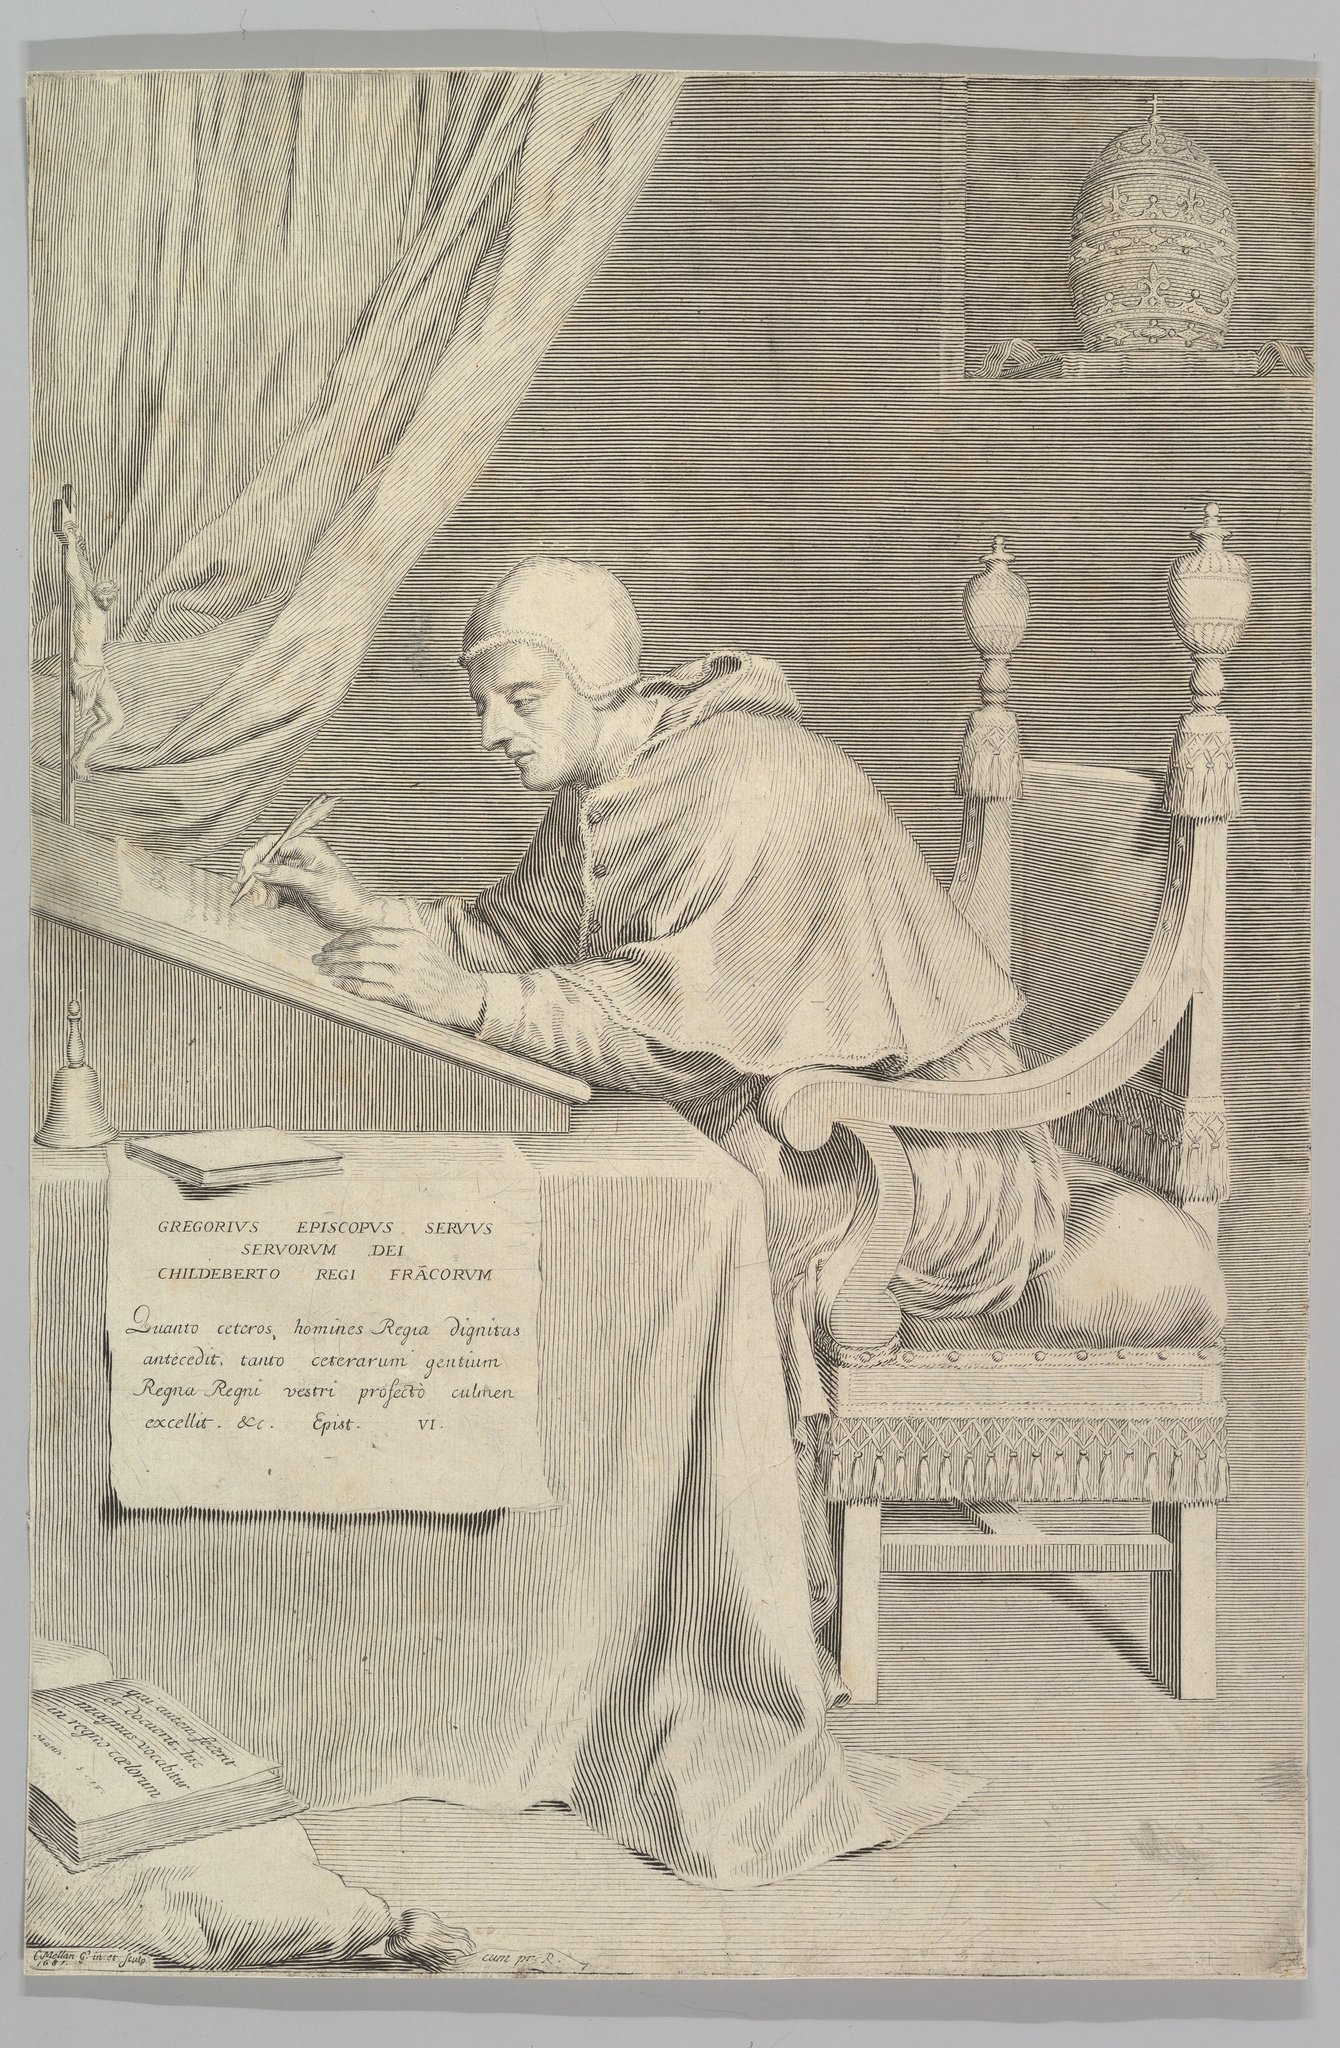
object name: print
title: St. Gregory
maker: claude mellan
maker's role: artist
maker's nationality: french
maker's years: 1598-1688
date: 1681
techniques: engraving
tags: men,saints,writing